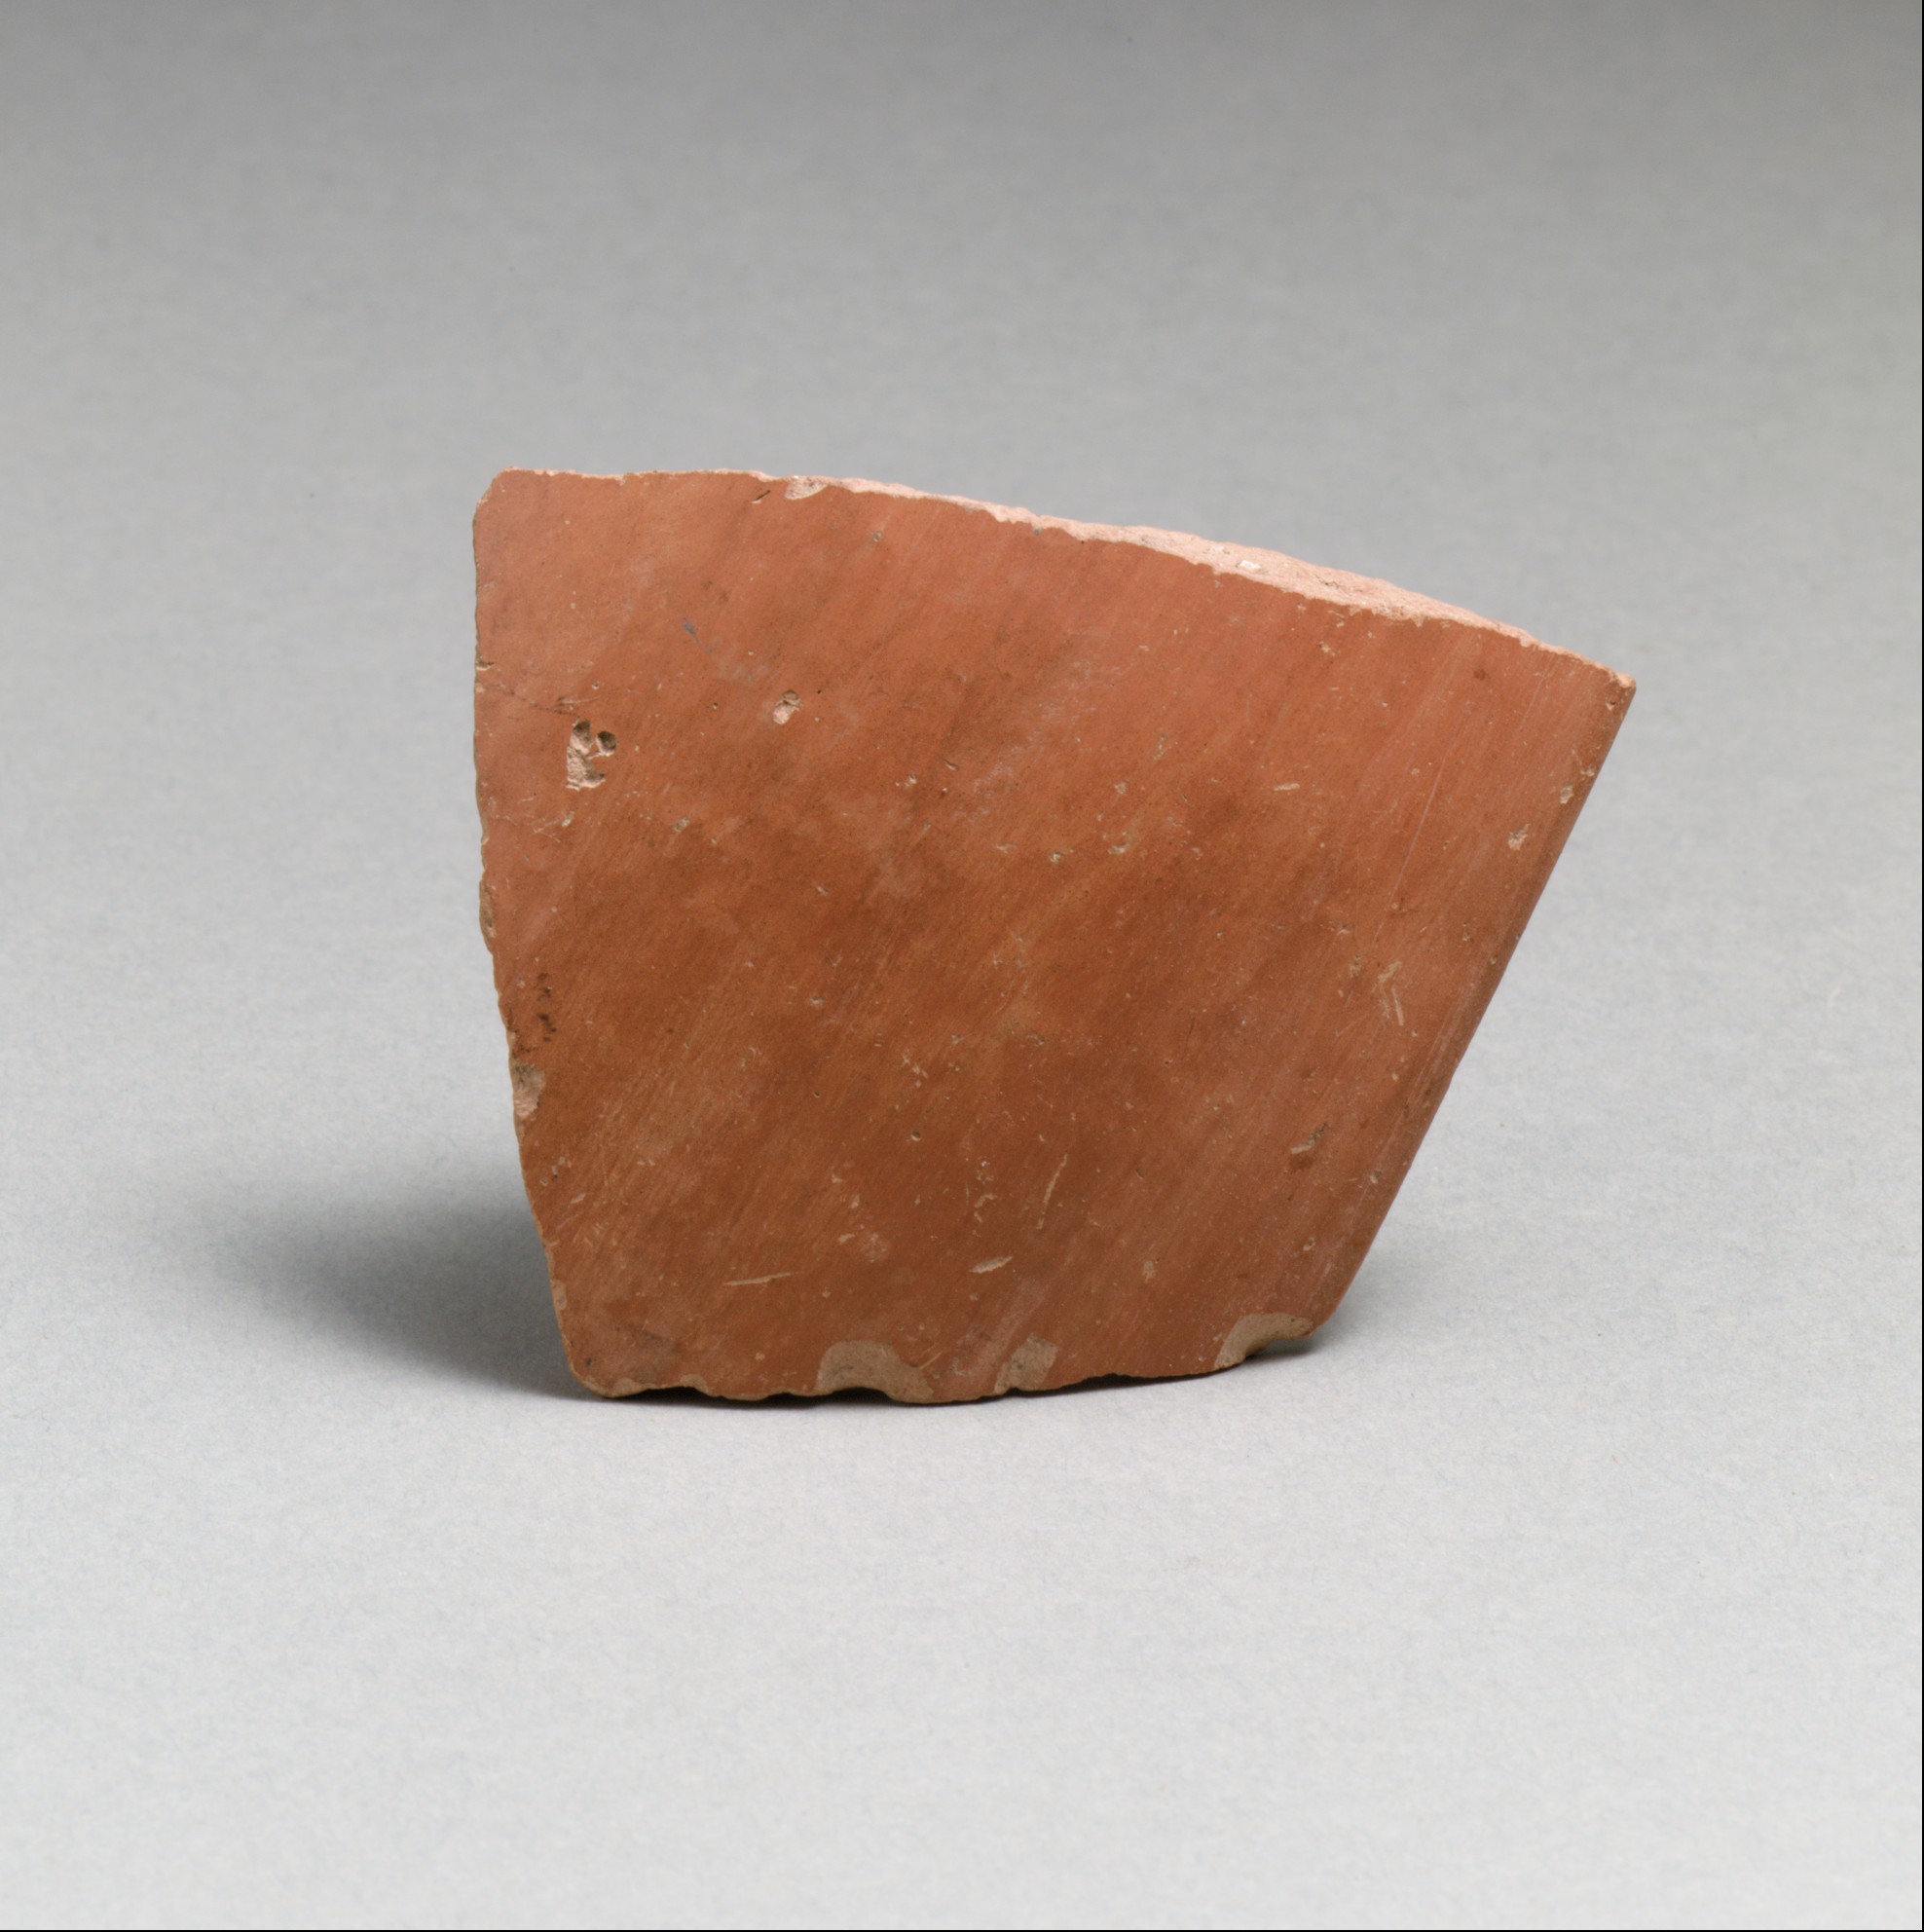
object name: vase fragment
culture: neolithic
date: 4000 BCE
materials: terracotta